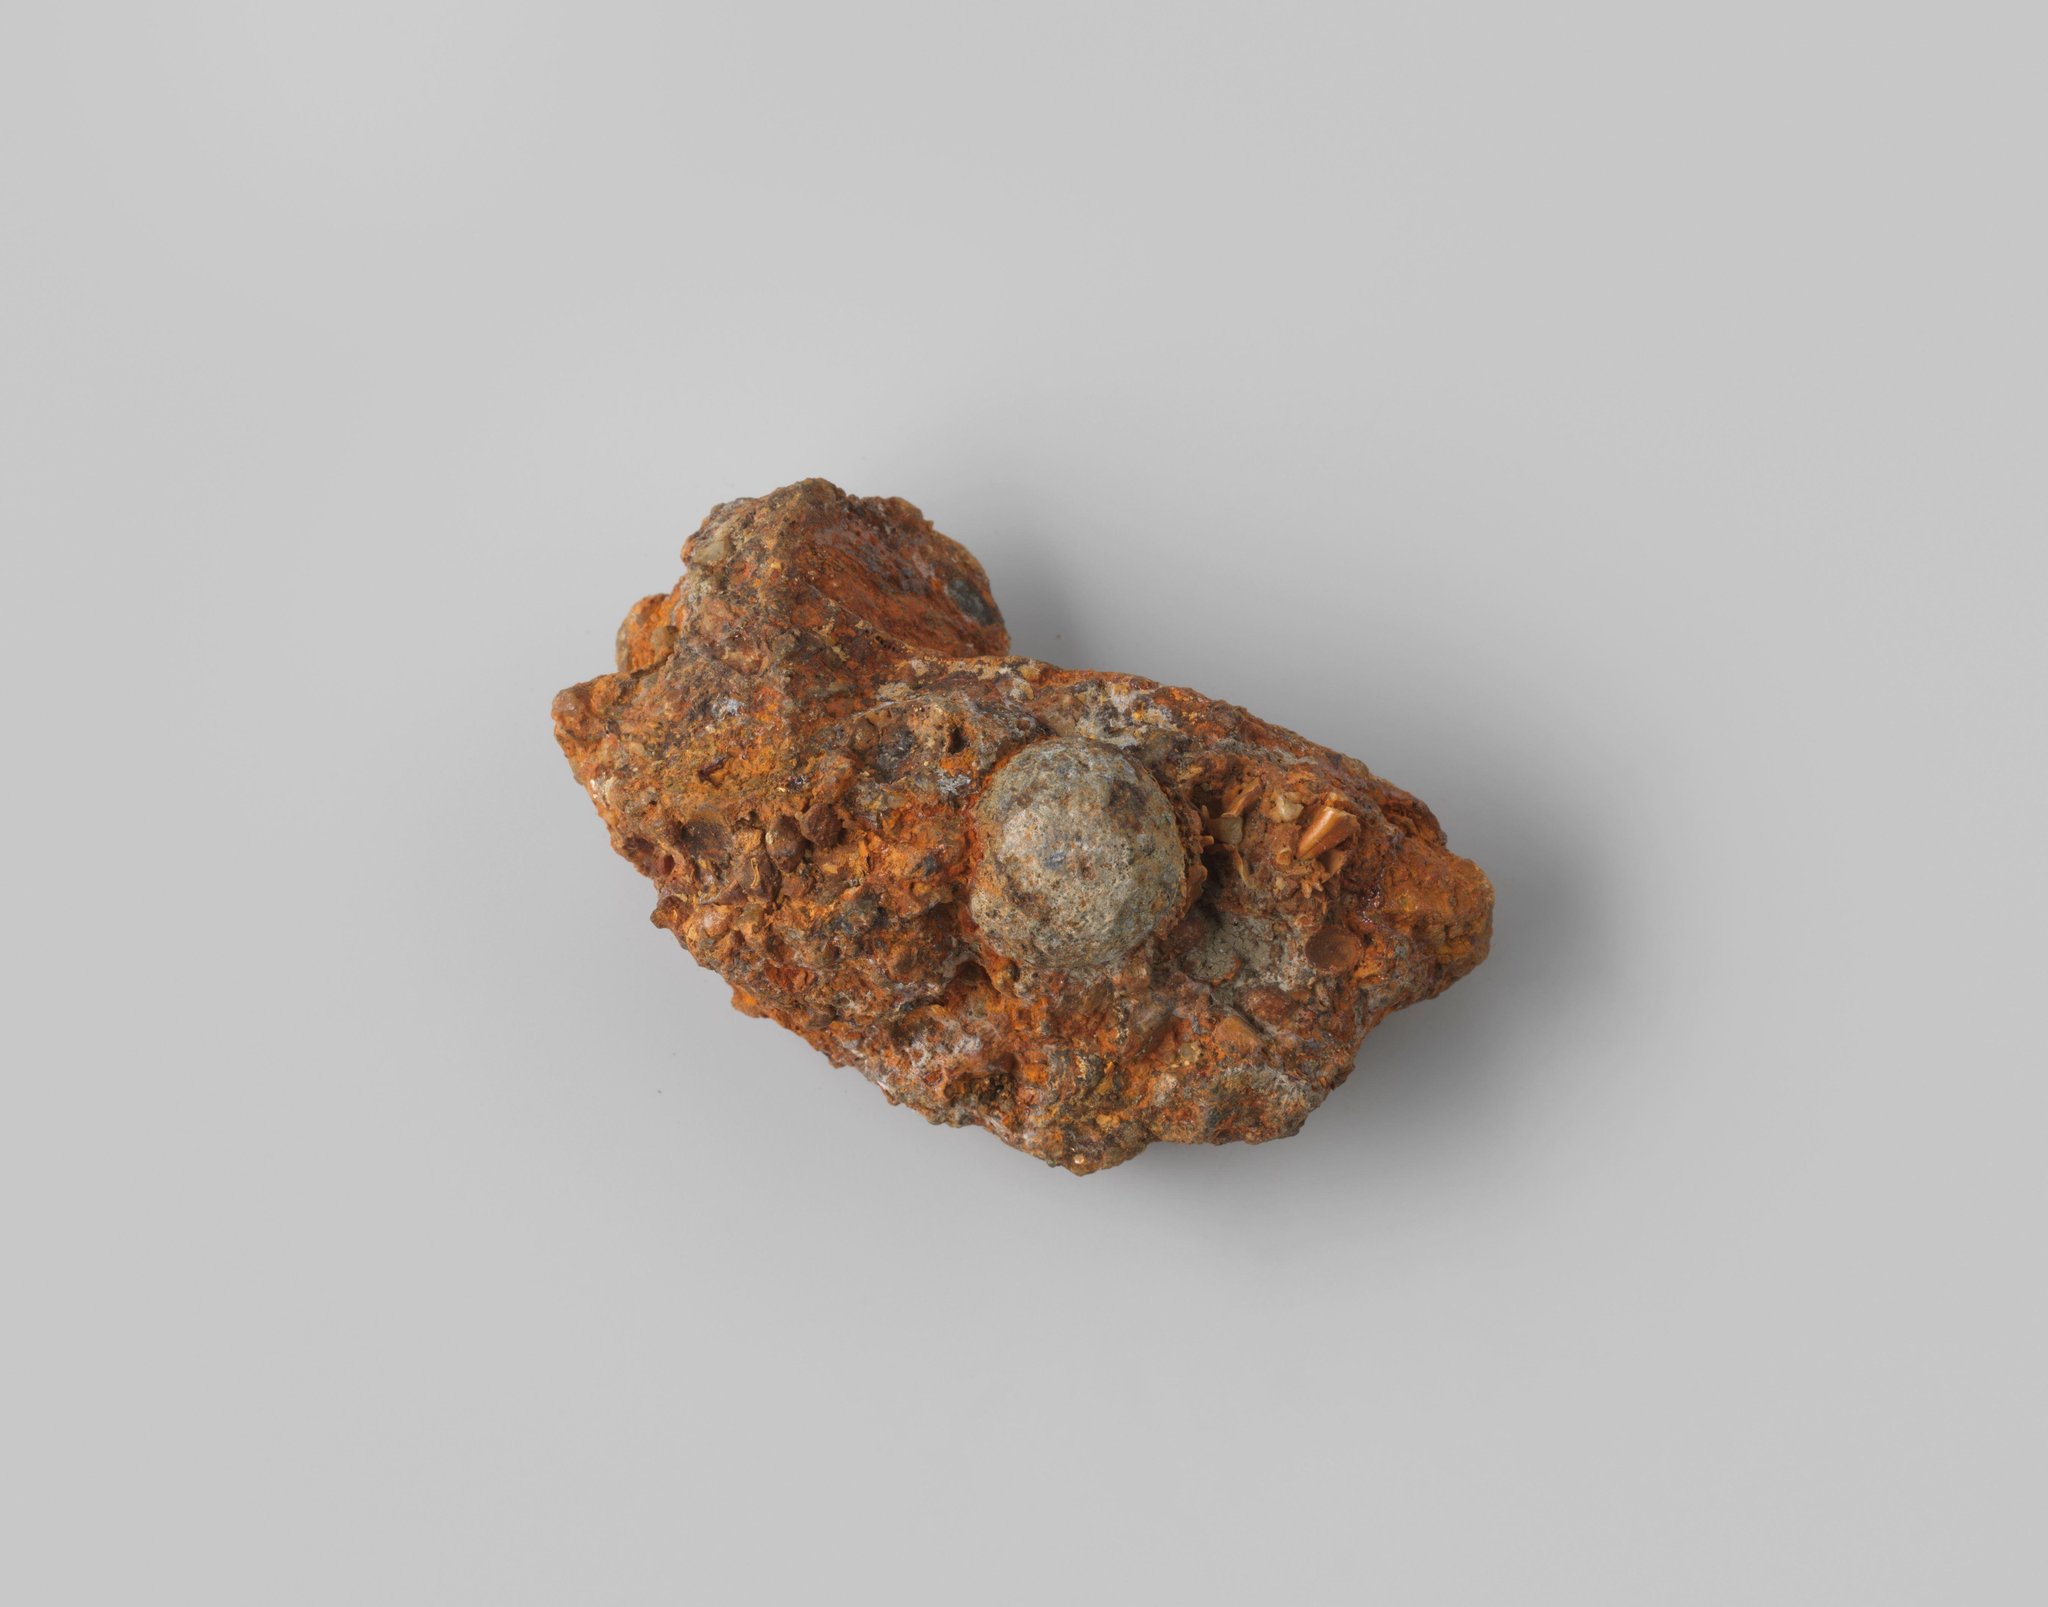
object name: musketkogel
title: Musketkogel in concretie uit het wrak van de Oost-Indiëvaarder Hollandia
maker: Anonymous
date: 1700-1743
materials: stone, lead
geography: netherlands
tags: verenigde oostindische compagnie, hollandia (schip), annet